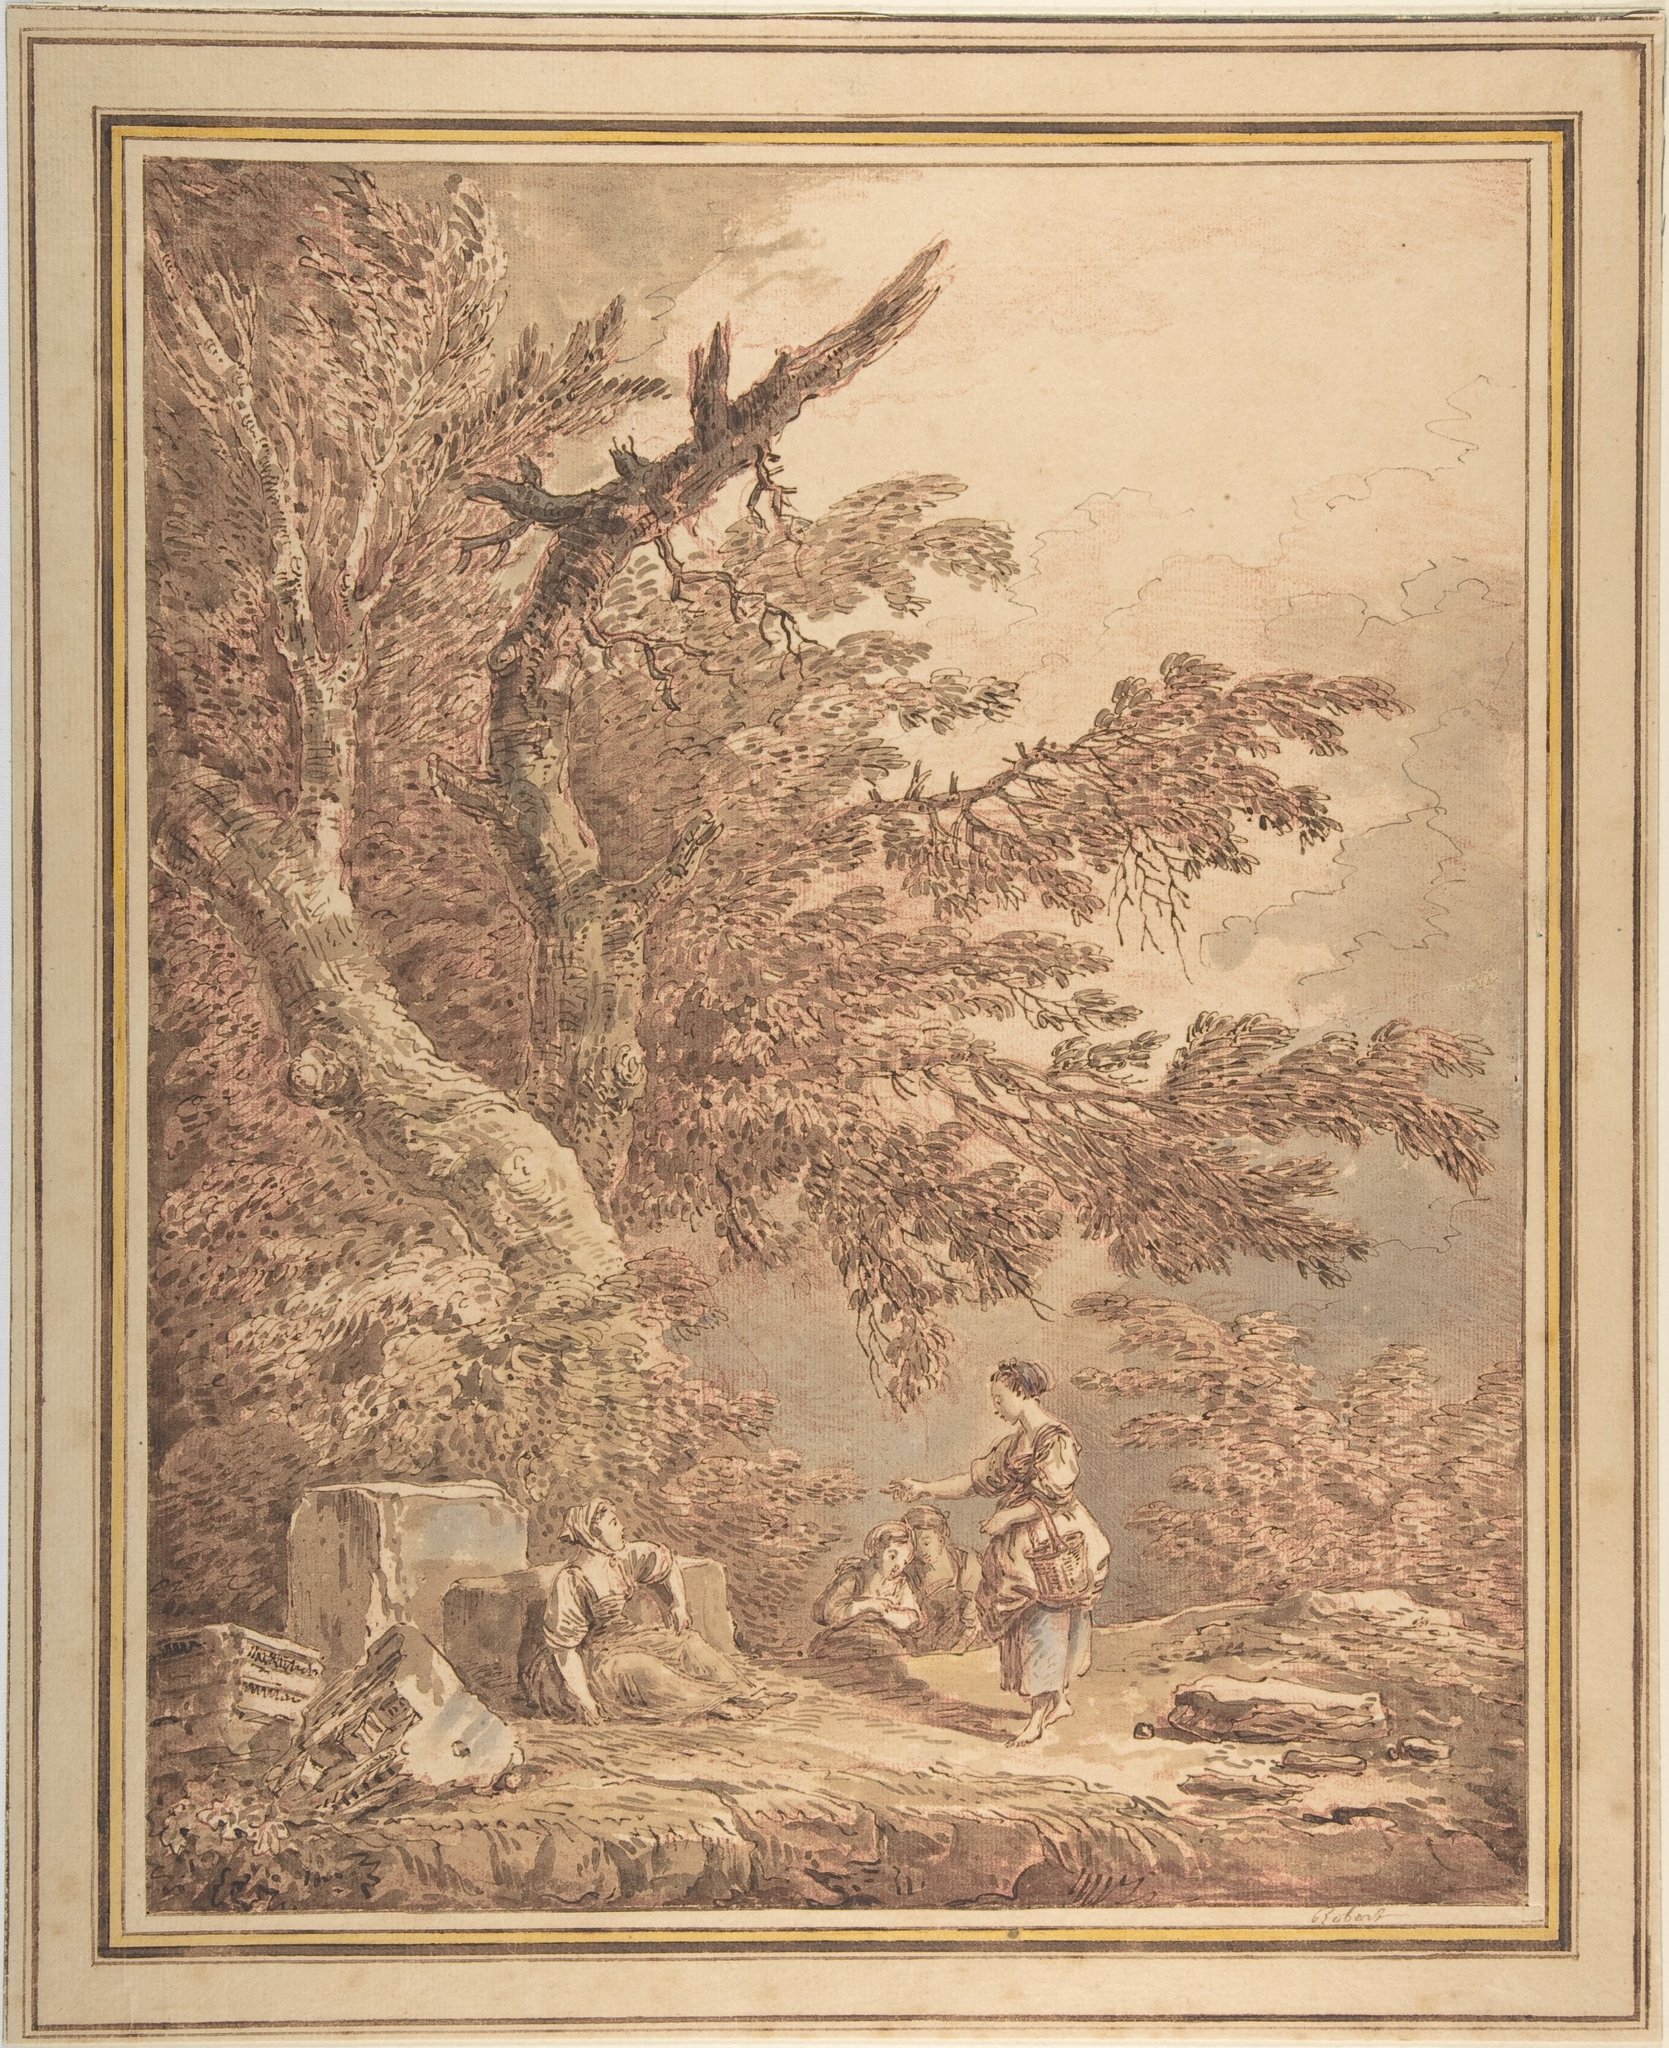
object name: drawing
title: Young Women in a Landscape with Architectural Fragments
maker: hubert robert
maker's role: artist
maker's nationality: french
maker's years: 1733-1808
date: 1773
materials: chalk, ink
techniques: brush, printmaking, pen, wash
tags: women,landscapes,trees